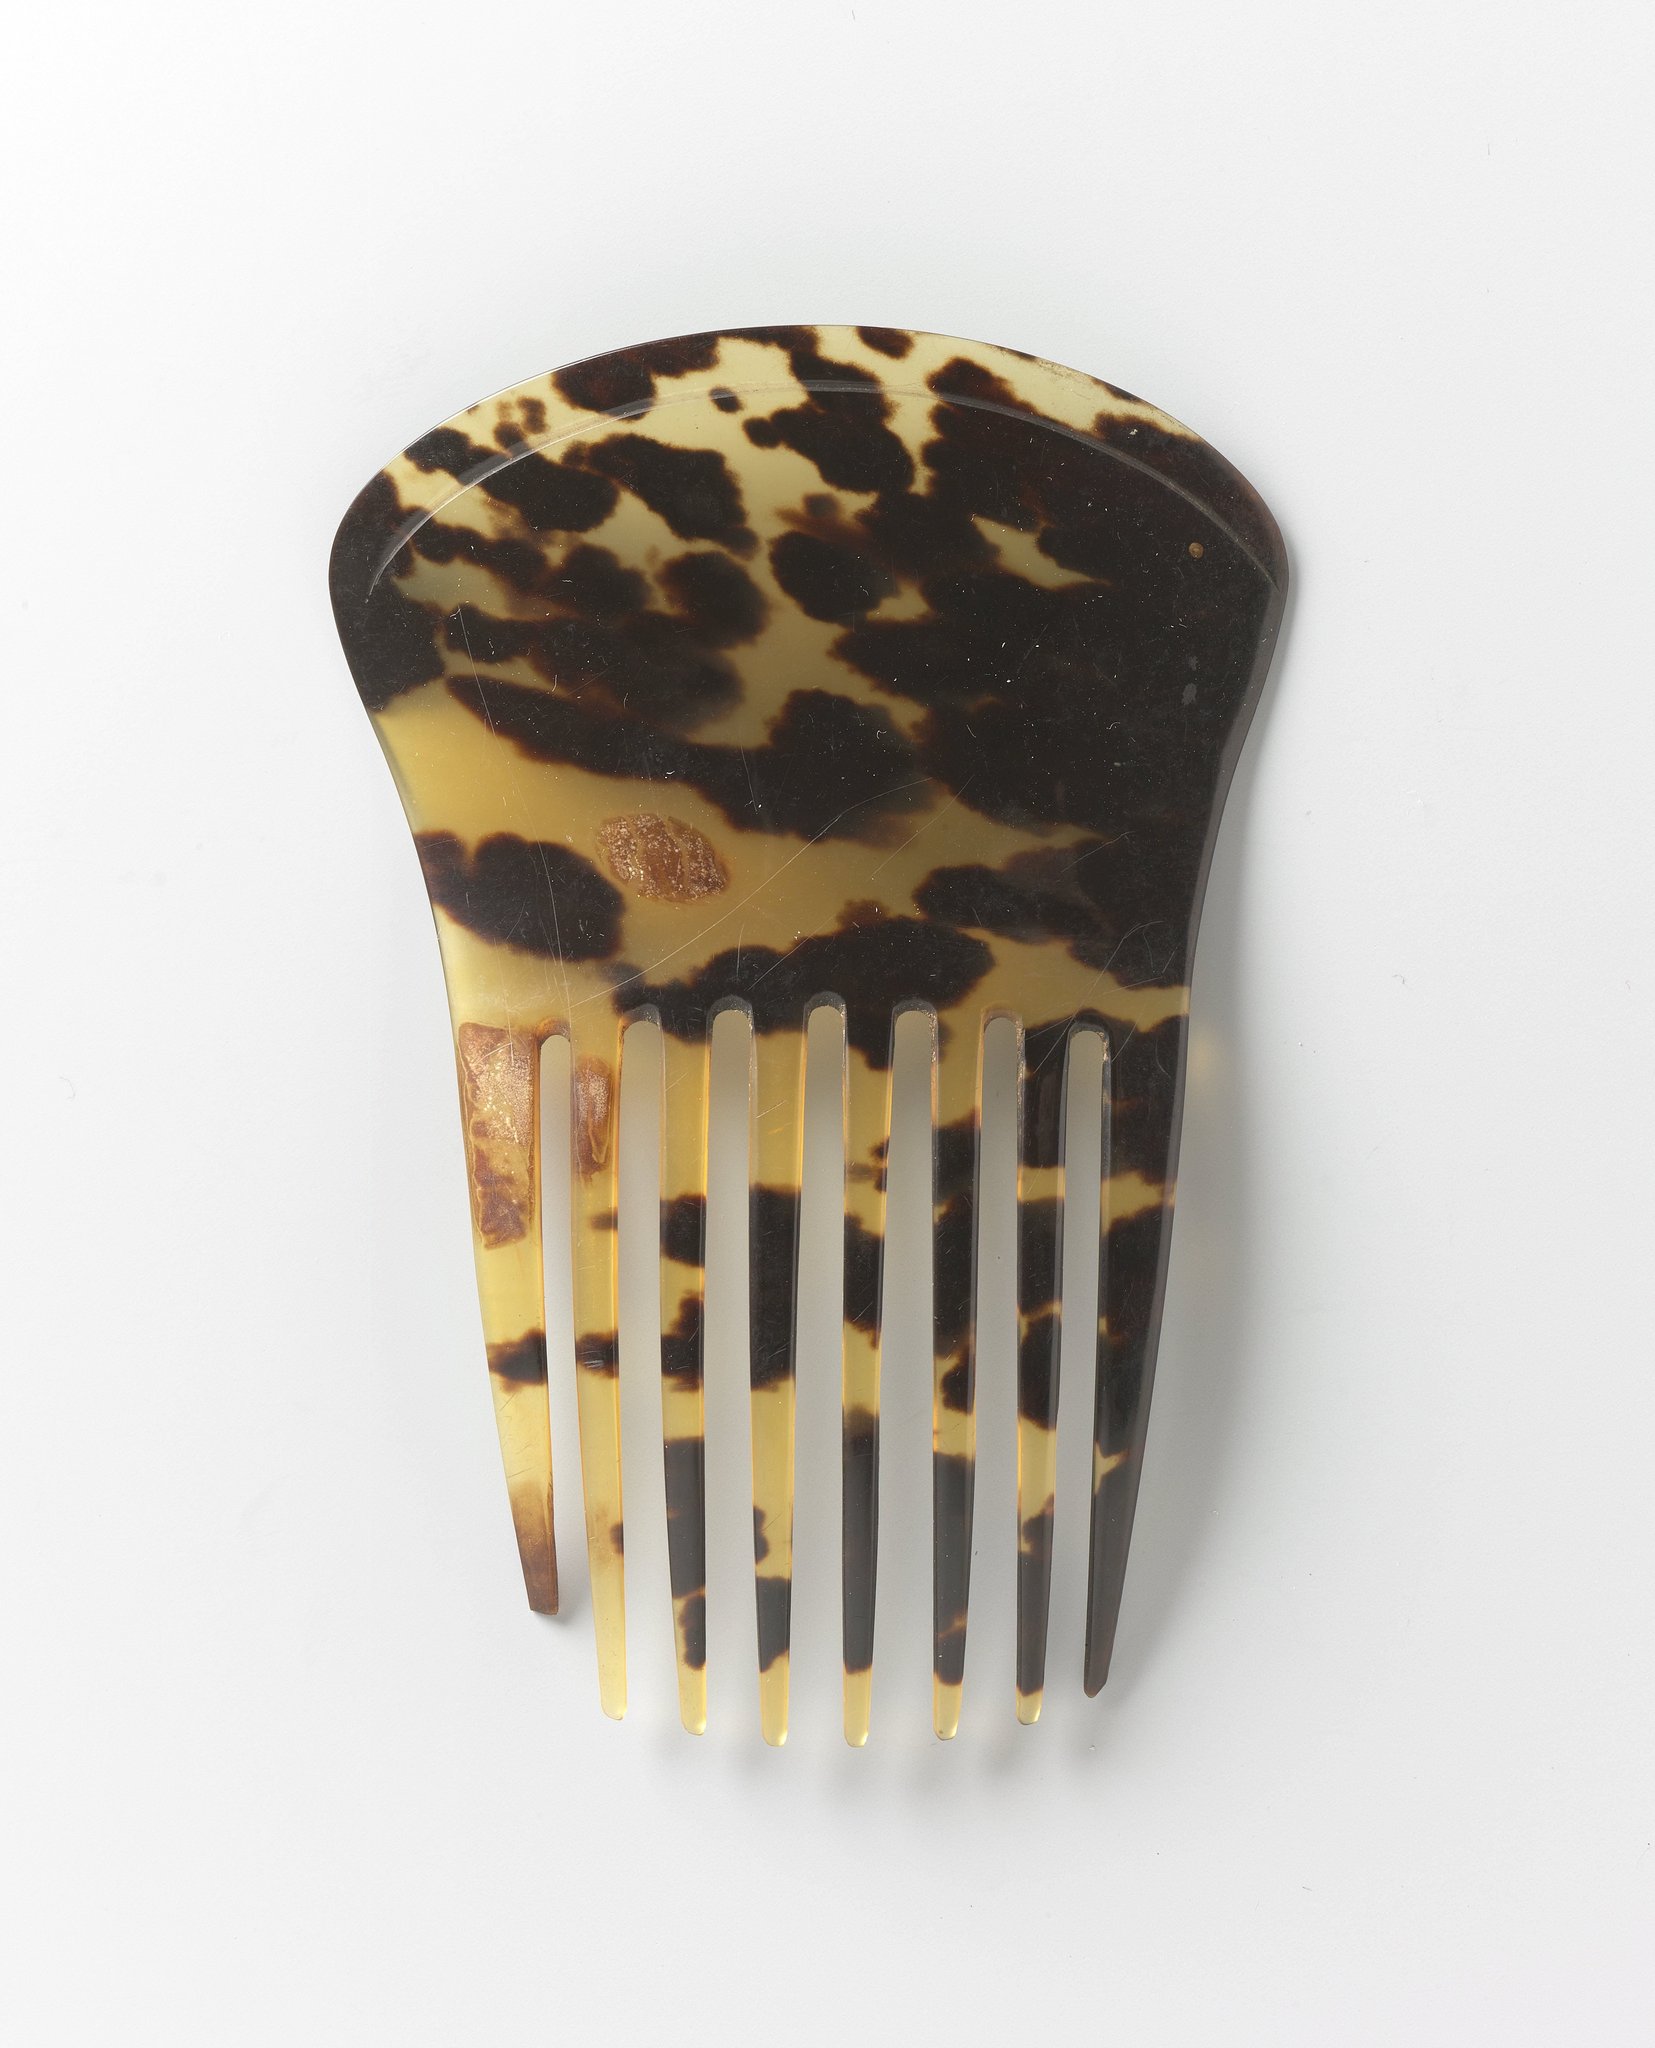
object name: comb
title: Haarkam van imitatie schildpad met gladde ovale rug, acht tanden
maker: Anonymous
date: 1885-1900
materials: celluloid, plastic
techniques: filing, polish, pressing, sawing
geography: netherlands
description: Een kleine trapezium-vormige mantille-kam van donker schildpad met glad bovenstuk en acht tanden.